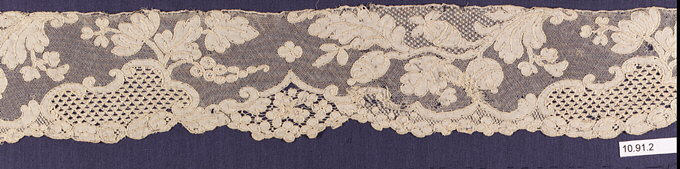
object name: fragment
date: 1801-1833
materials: lace